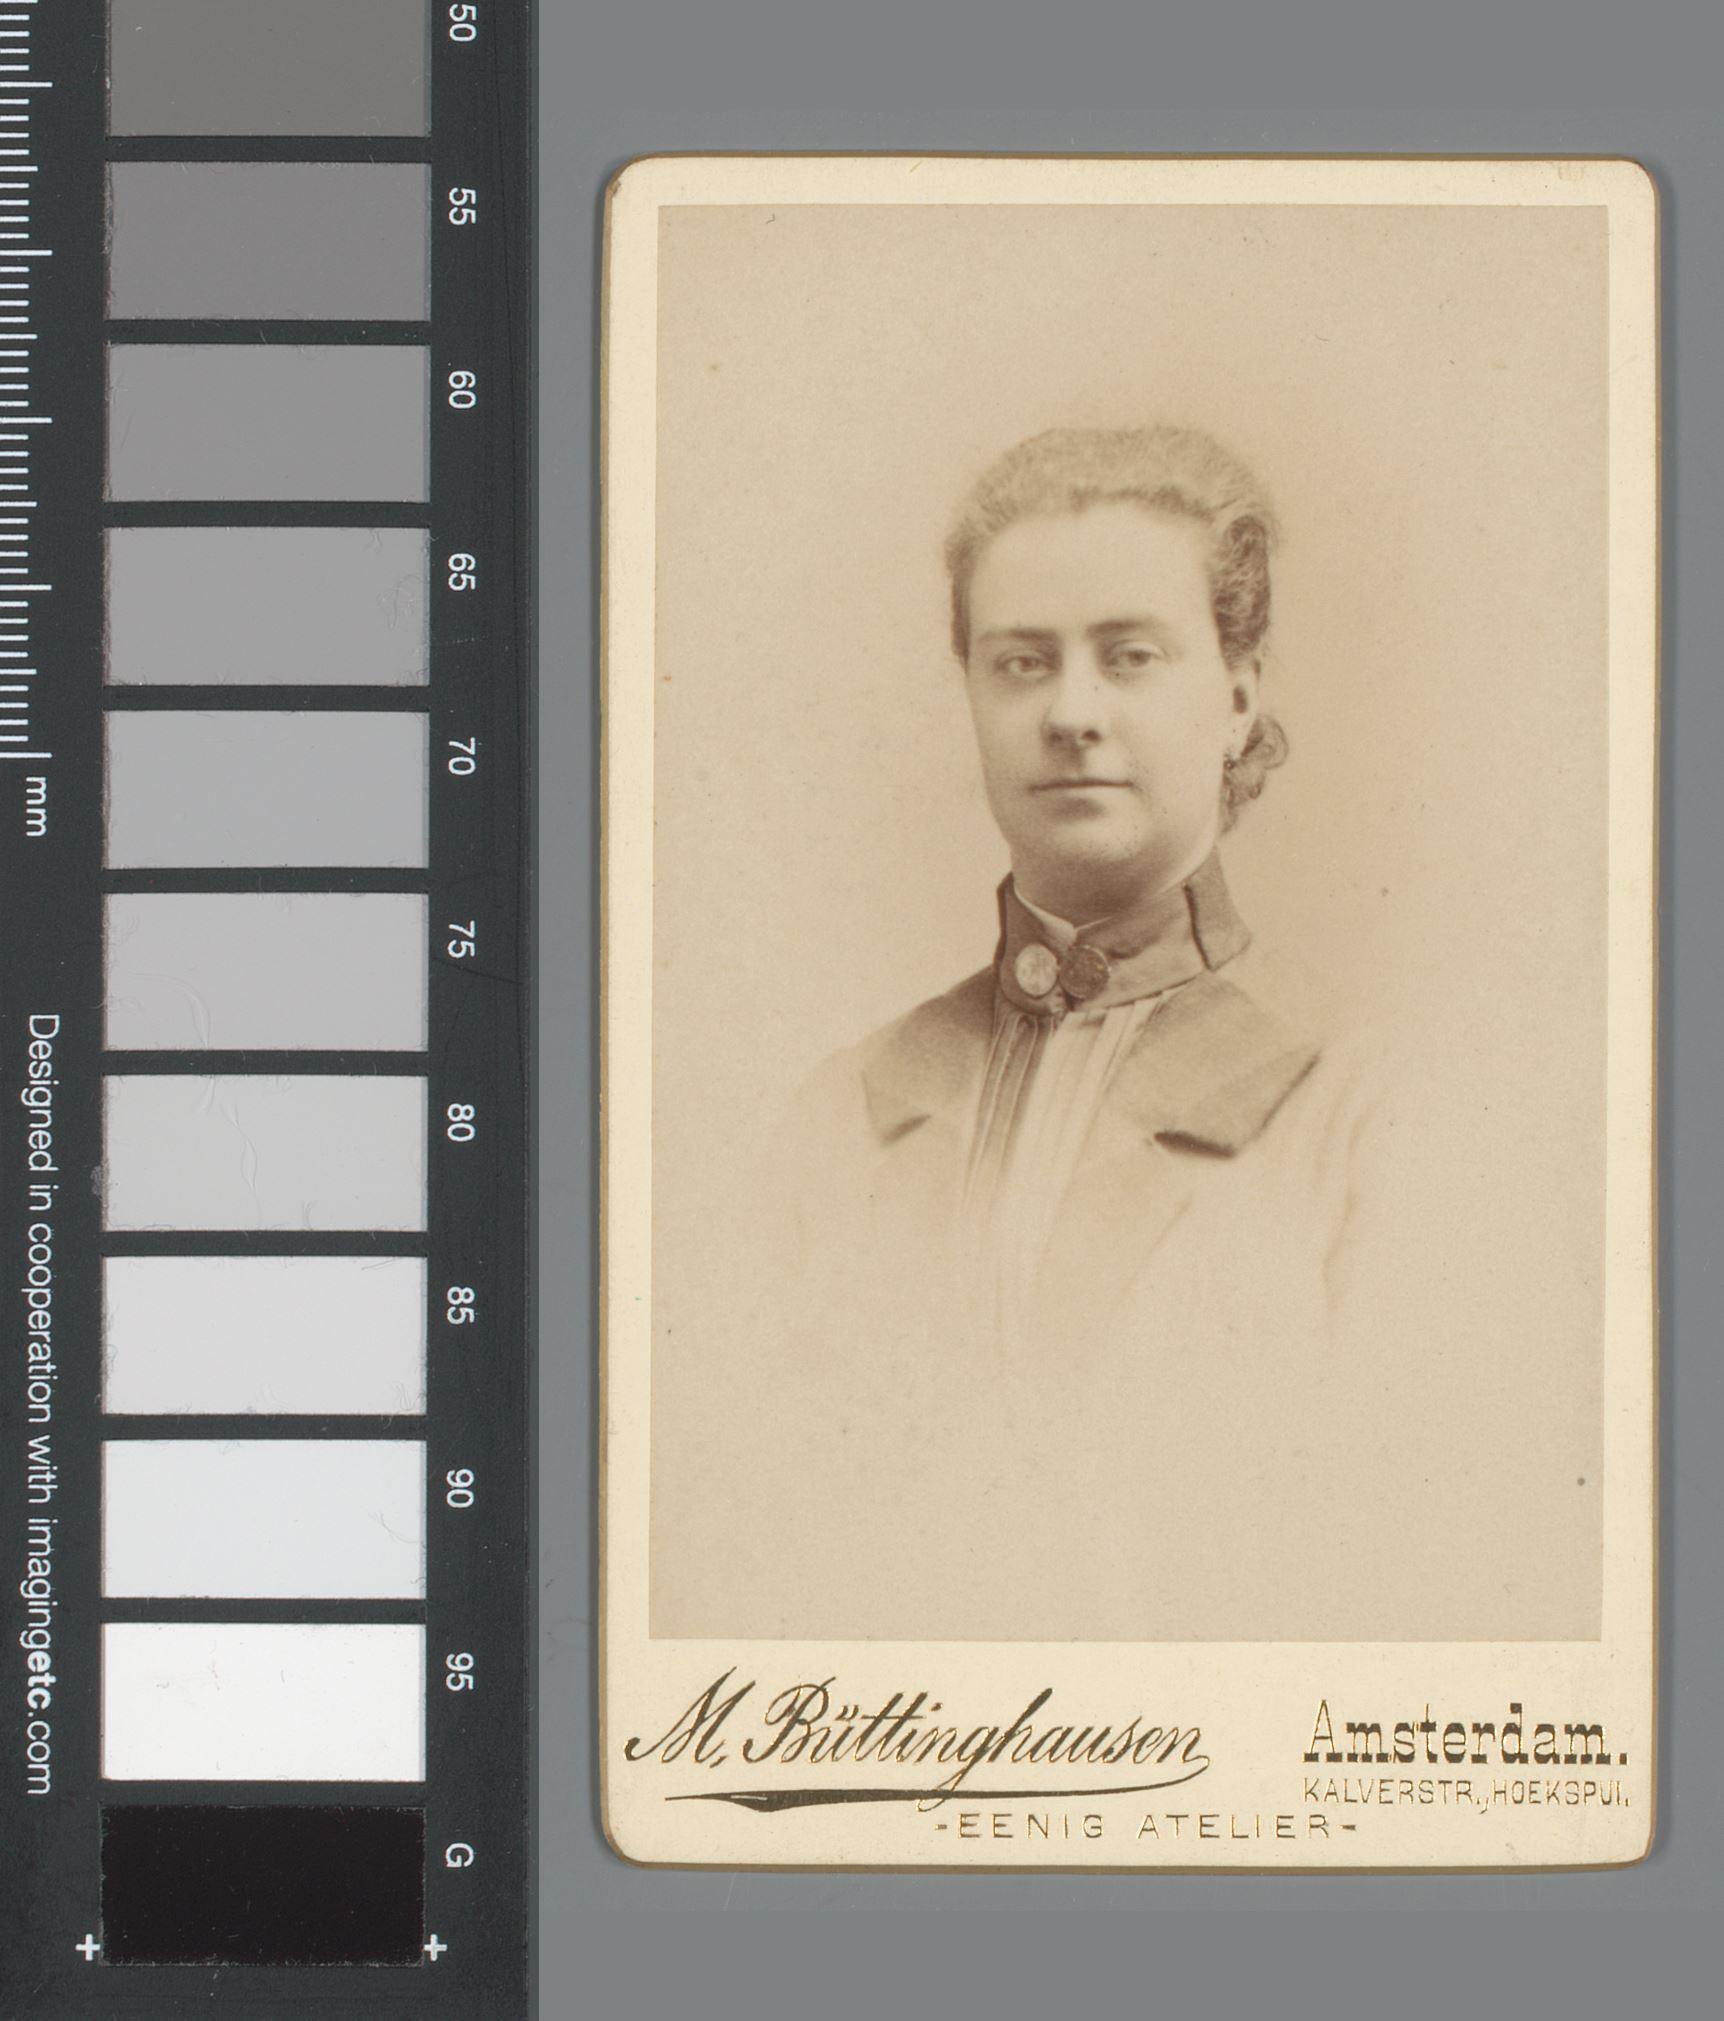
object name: photograph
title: Portret van Neletta Jonker van der Linden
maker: max büttinghausen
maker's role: fotograaf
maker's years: 1847-1906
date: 1899-1906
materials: cardboard, photographic support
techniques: albumen print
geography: amsterdam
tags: haarlem, historical persons, amsterdam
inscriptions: workshop stamp: ‘M. Büttinghausen/ Amsterdam, eening atelier/ Kalverstraat, hoek Spui’, annotation: ‘Oma Jonker’